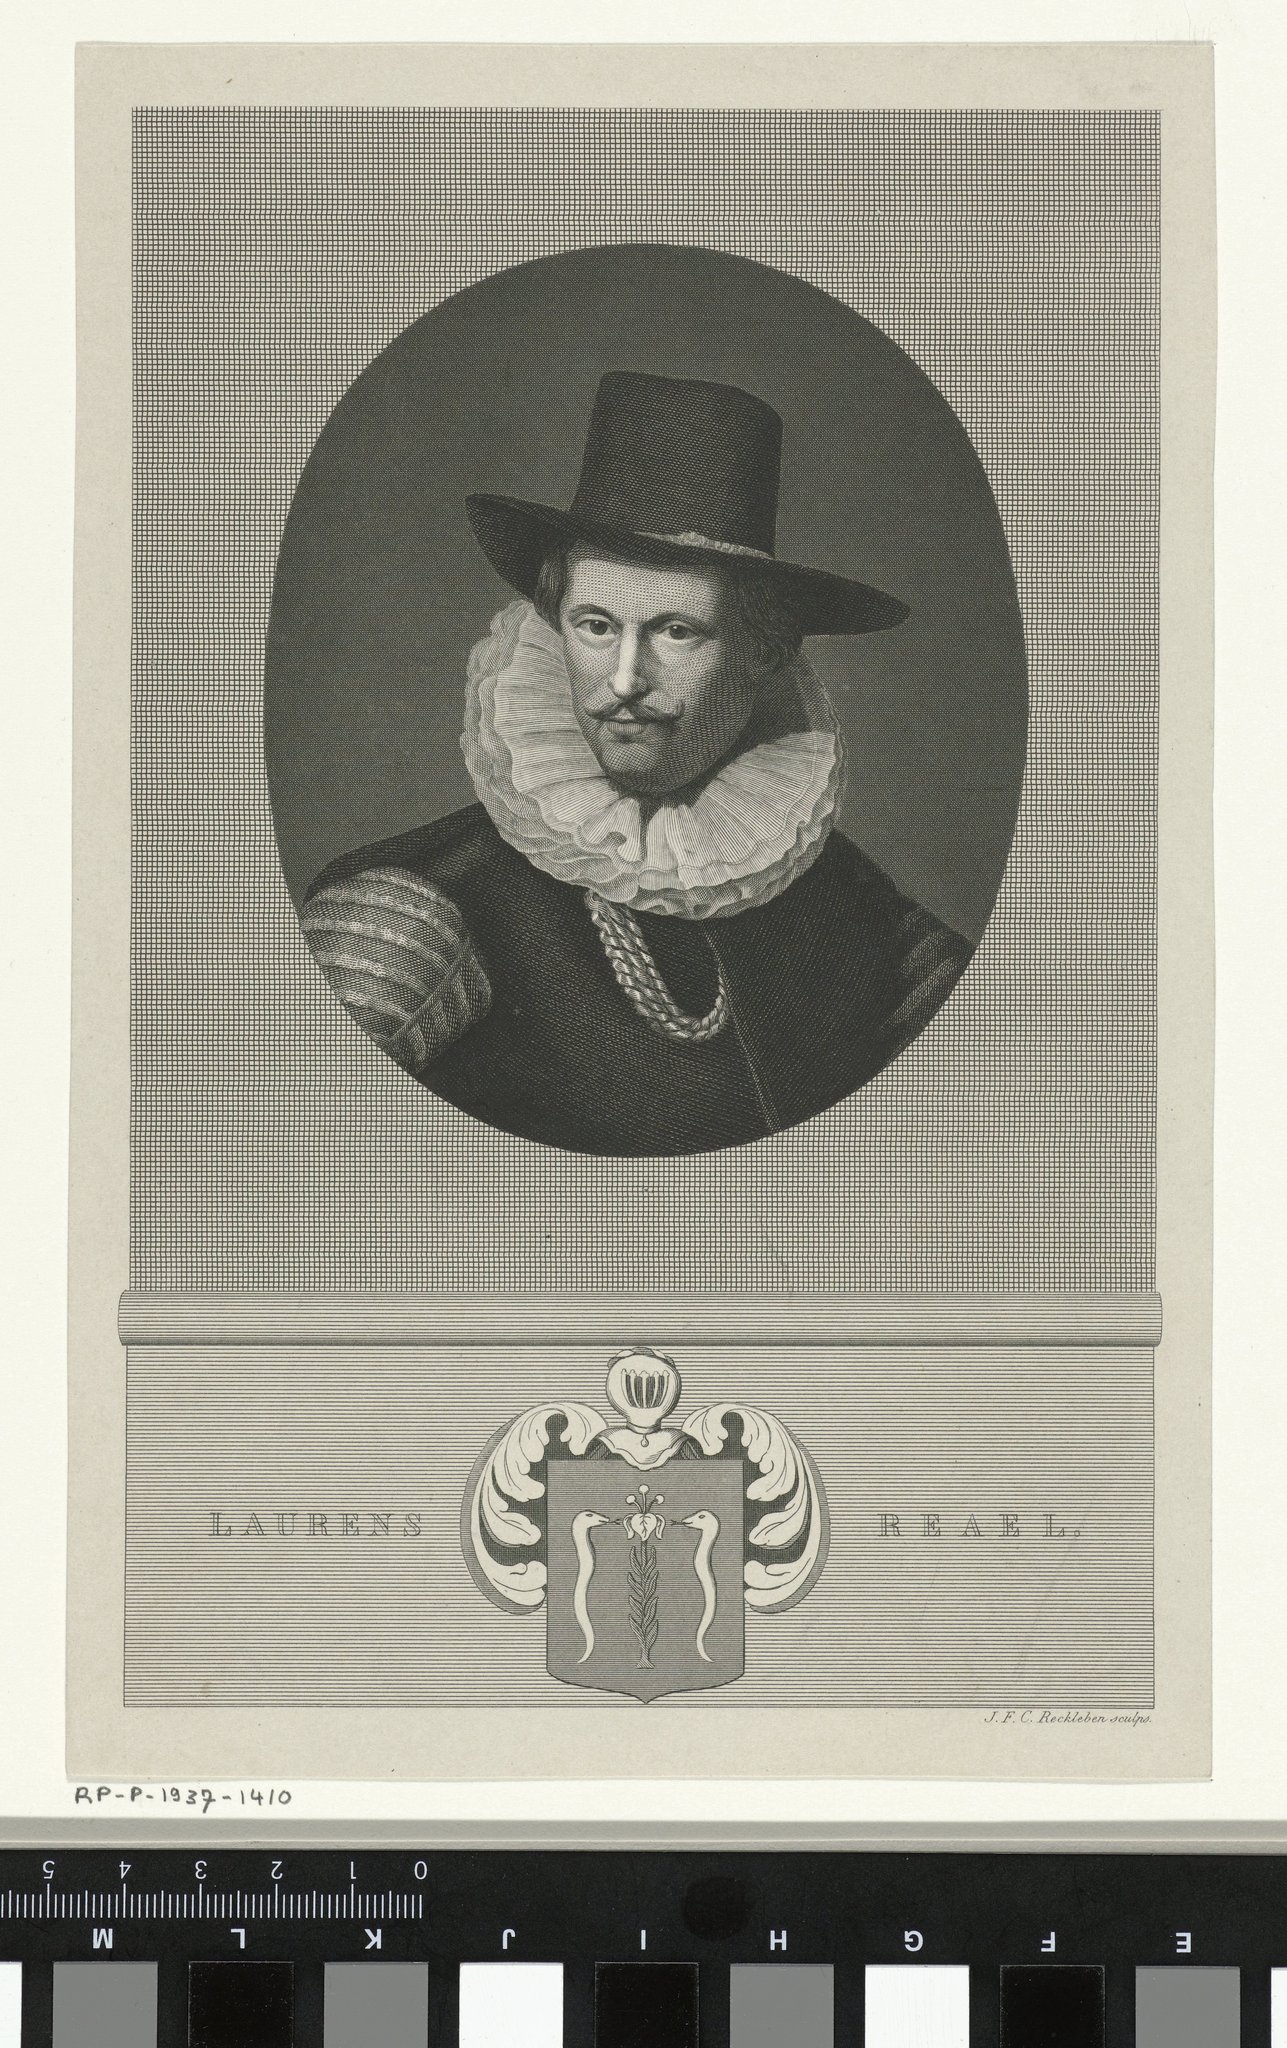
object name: print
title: Portret van Laurens Reael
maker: jan frederik christiaan reckleben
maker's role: print maker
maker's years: 1819-1879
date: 1861-1863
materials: paper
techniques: engraving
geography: amsterdam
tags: laurens reael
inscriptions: collector's mark: Lugt 2228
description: Portret van Laurens Reael, gouverneur-generaal van Nederlands Oost-Indië (1616-19), en sedert 1625 bewindhebber van de Verenigde Oostindische Compagnie te Amsterdam. In de marge zijn naam en familiewapen.